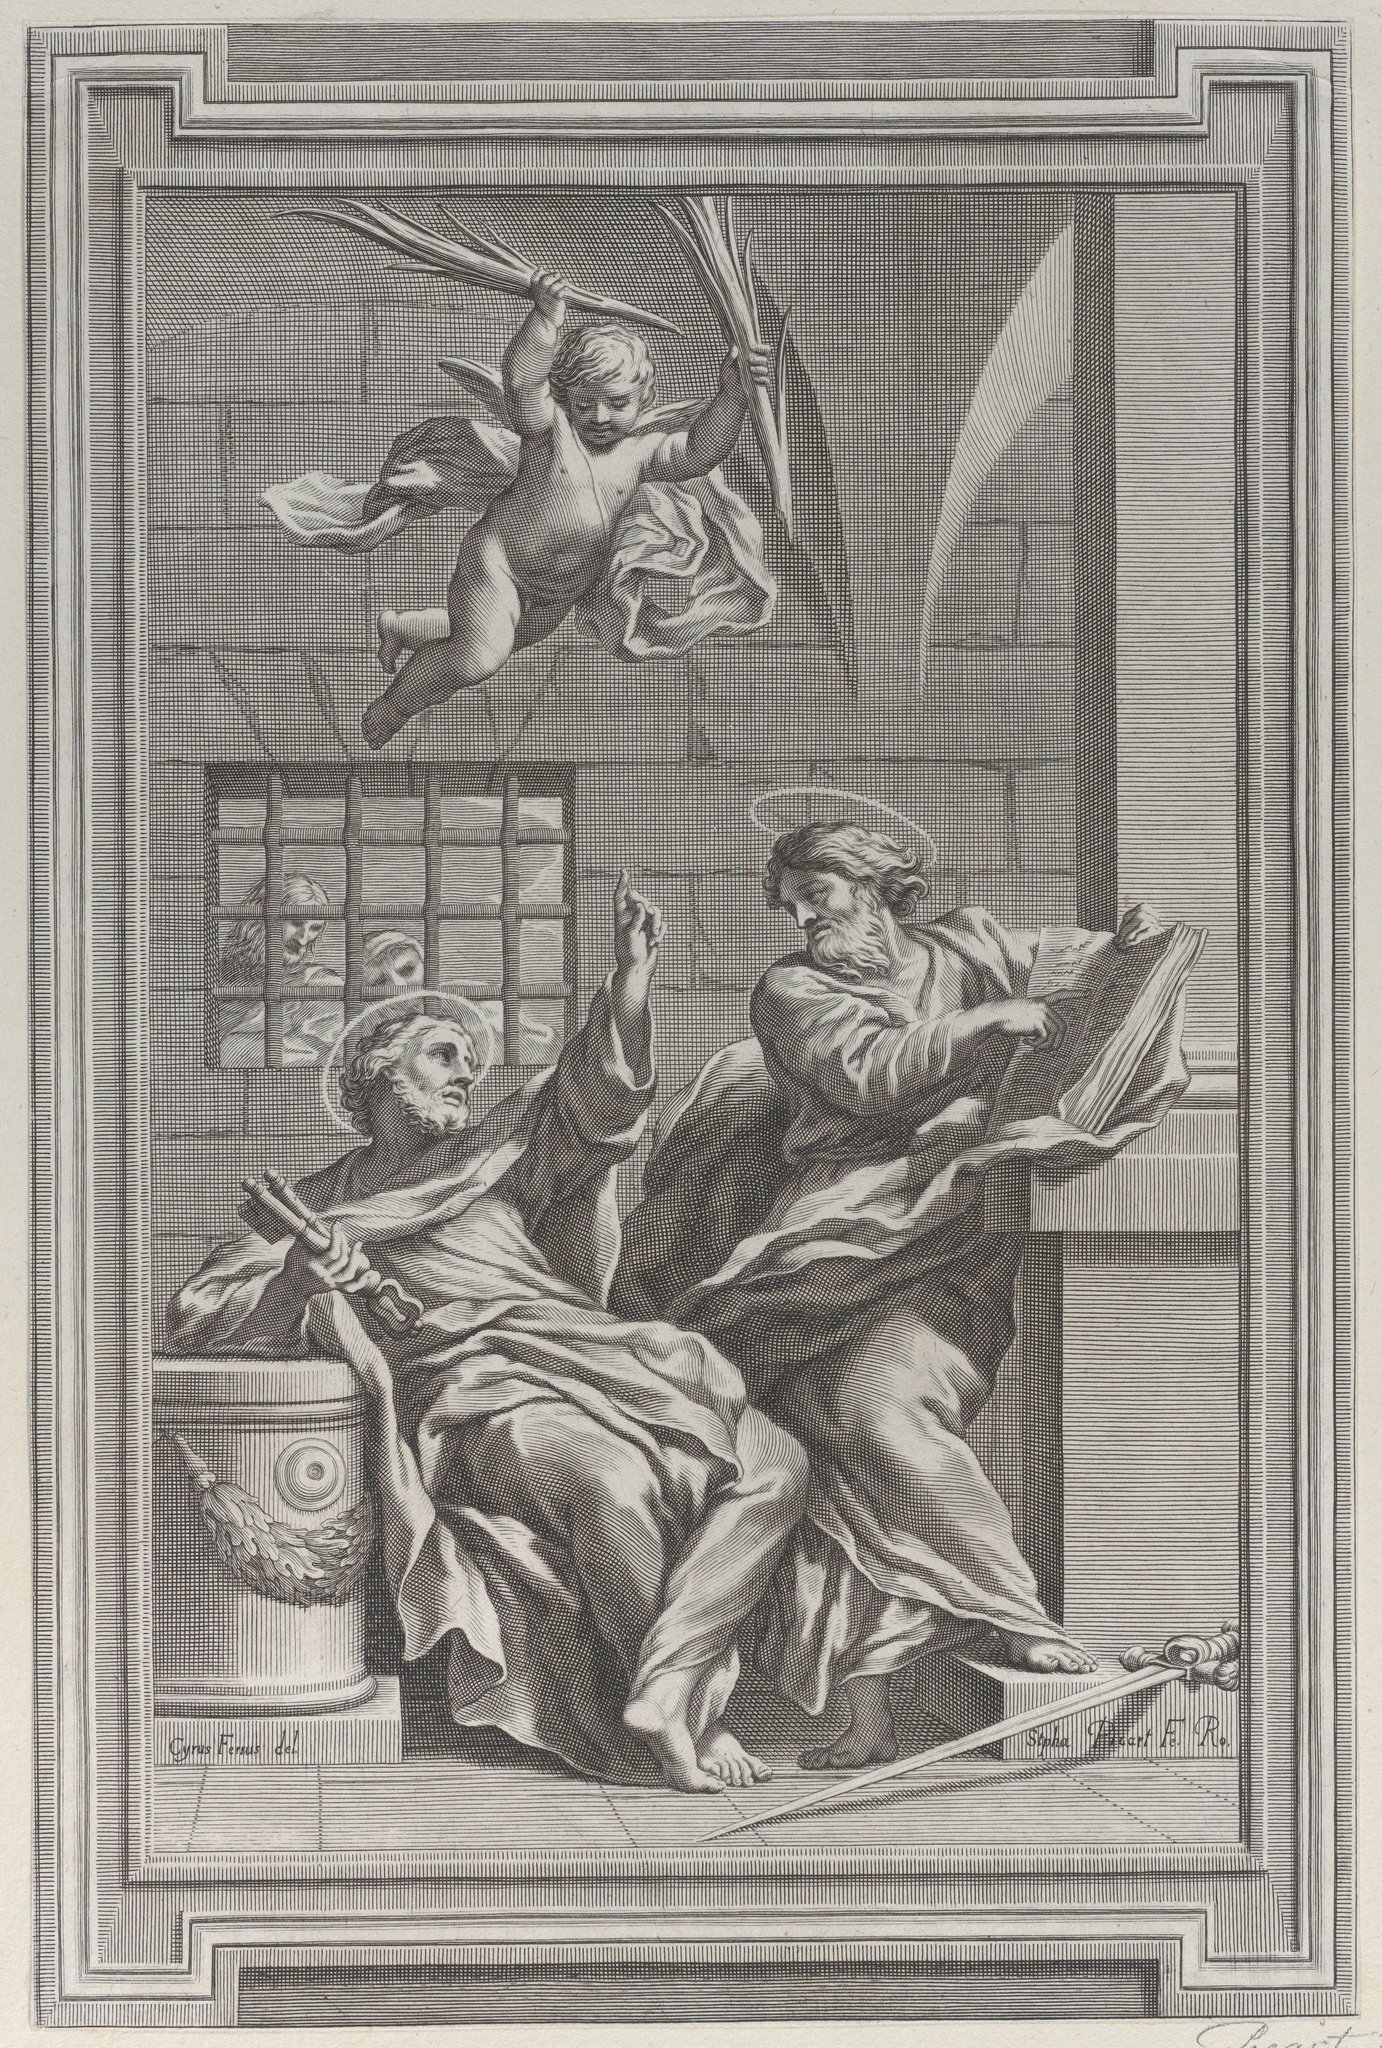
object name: print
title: Saints Peter and Paul in prison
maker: etienne picart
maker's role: artist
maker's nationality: french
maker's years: 1632-1721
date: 1660-1721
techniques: engraving